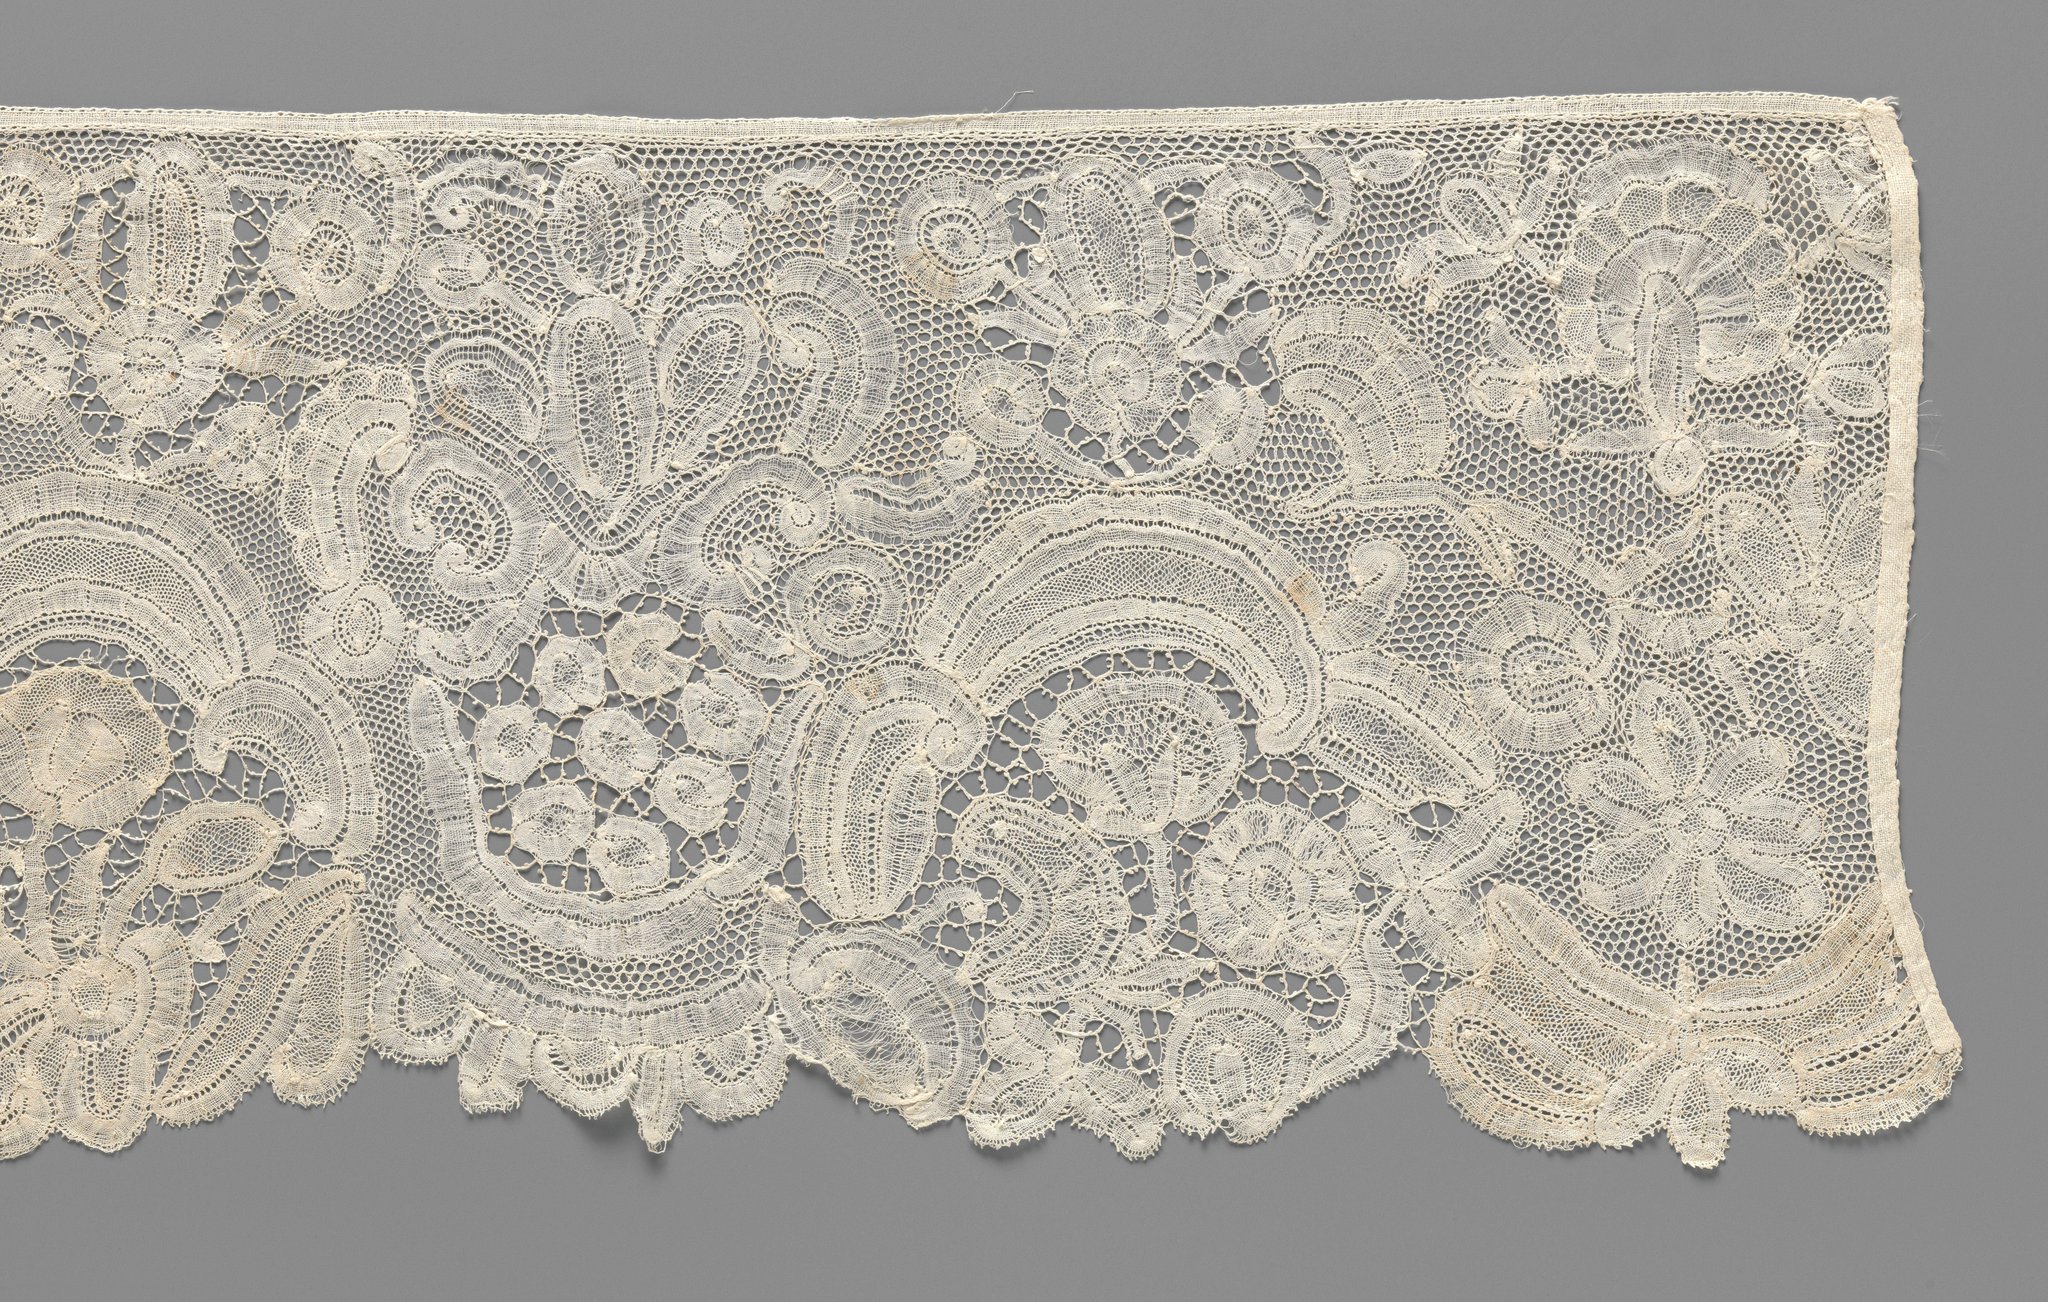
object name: strip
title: Strook kloskant met veelsoortige bloemen en bogen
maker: Anonymous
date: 1700-1749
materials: linen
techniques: lace, old brabant lace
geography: southern netherlands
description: Strook naturelkleurige kloskant: Brabantse kant. Het betreft twee aaneengenaaide manchetten van een koorhemd. Het zich herhalende patroon bestaat uit een grote verscheidenheid aan bloemen en bladeren die over elkaar heen buitelen. Opvallend zijn de dikke bladeren of c-voluten, die rond de middenas op enige afstand van elkaar bogen vormen. Onder elk boog staat een vergelijkbare compositie met een ovale (kelk)bloem op een lichtgebogen steel. De velden tussen de bogen worden op afwisselende wijze gevuld, onder andere met een u-vormige omlijsting waarin acht rozetbloemen een cirkel vormen, bekroond door een compositie met c-voluten en ovalen. De motieven zijn gemaakt in netslag en linnenslag met opengewerkte randjes en uitsparingen. Er is zeer spaarzaam gebruik gemaakt van contourdraden om sommige motiefdelen te accentueren. De motieven zijn grotendeels met elkaar verbonden door een traliegrond, een Parijse grond. De motieven onder de bogen zijn met elkaar verbonden door een gepicoteerde vlechtengrond. Deze vlechtengrond is ook op enkele andere plaatsen gebruikt, waaronder tussen de rozetbloemen in de u-vormige omlijsting. In sommige motieven is een siergrond toegepast. De bovenzijde van de strook is recht afgewerkt met een apart geklost linnen bandje. De onregelmatige schulpenrand langs de onderzijde van de strook komt voort uit het patroon en is afgewerkt met picots.